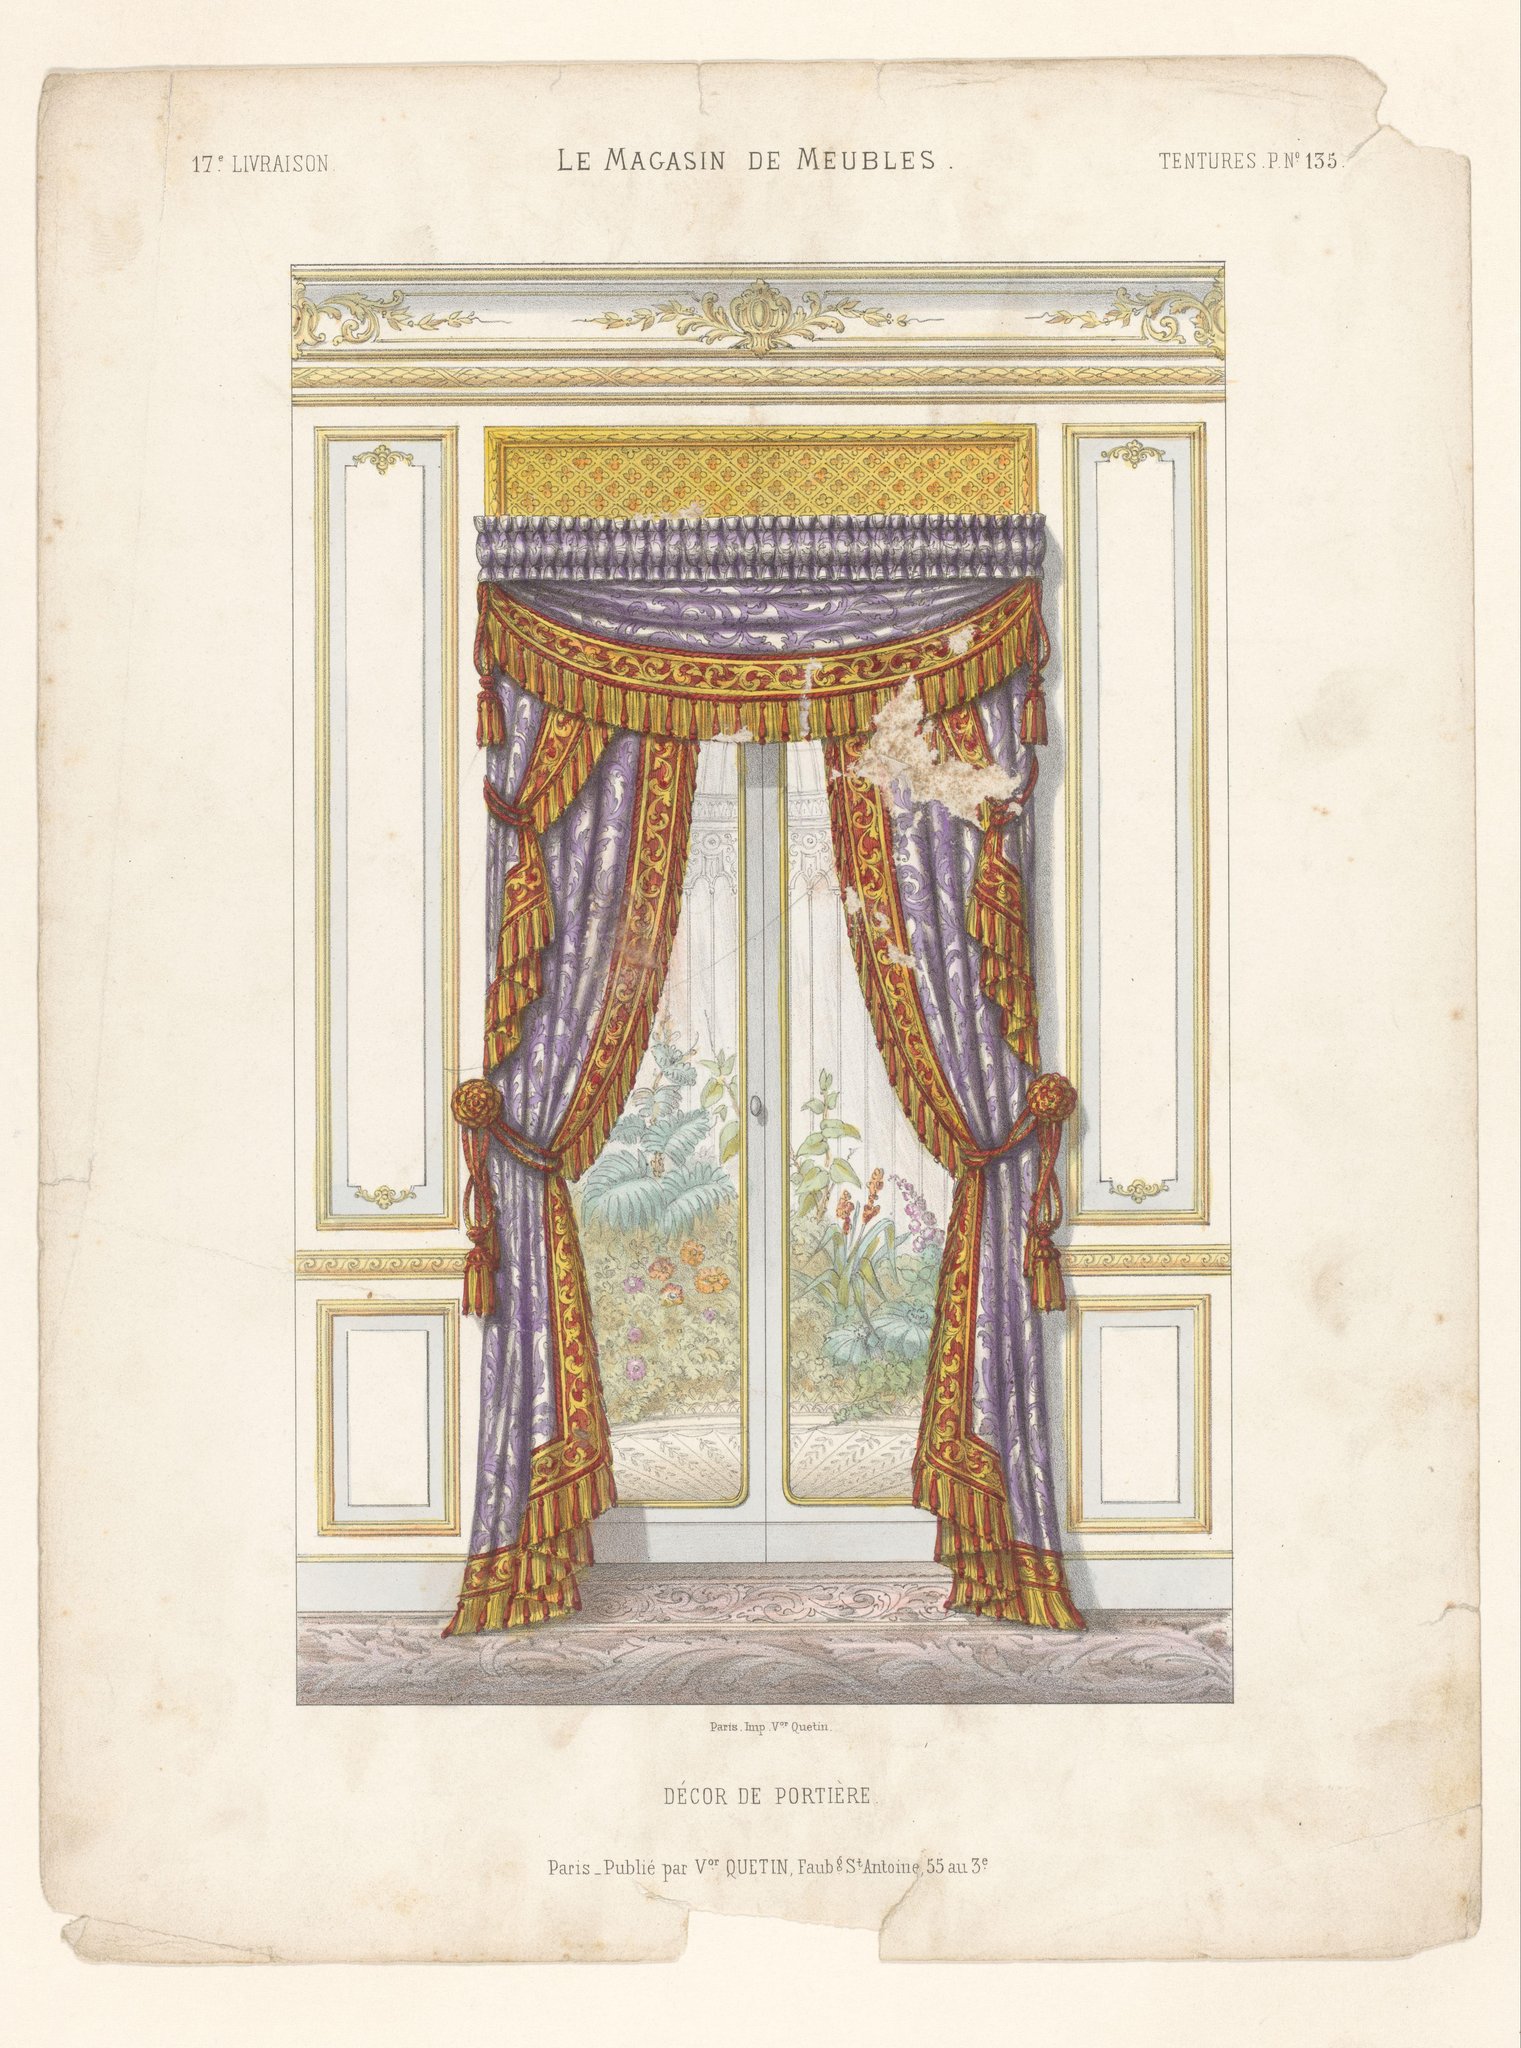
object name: print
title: Décor de portière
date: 1832-1877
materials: paper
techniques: hand coloring, lithograph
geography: paris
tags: door, hangings and drapery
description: Een deur met gedrapeerde gordijnen. Prent uit 17e Livraison.